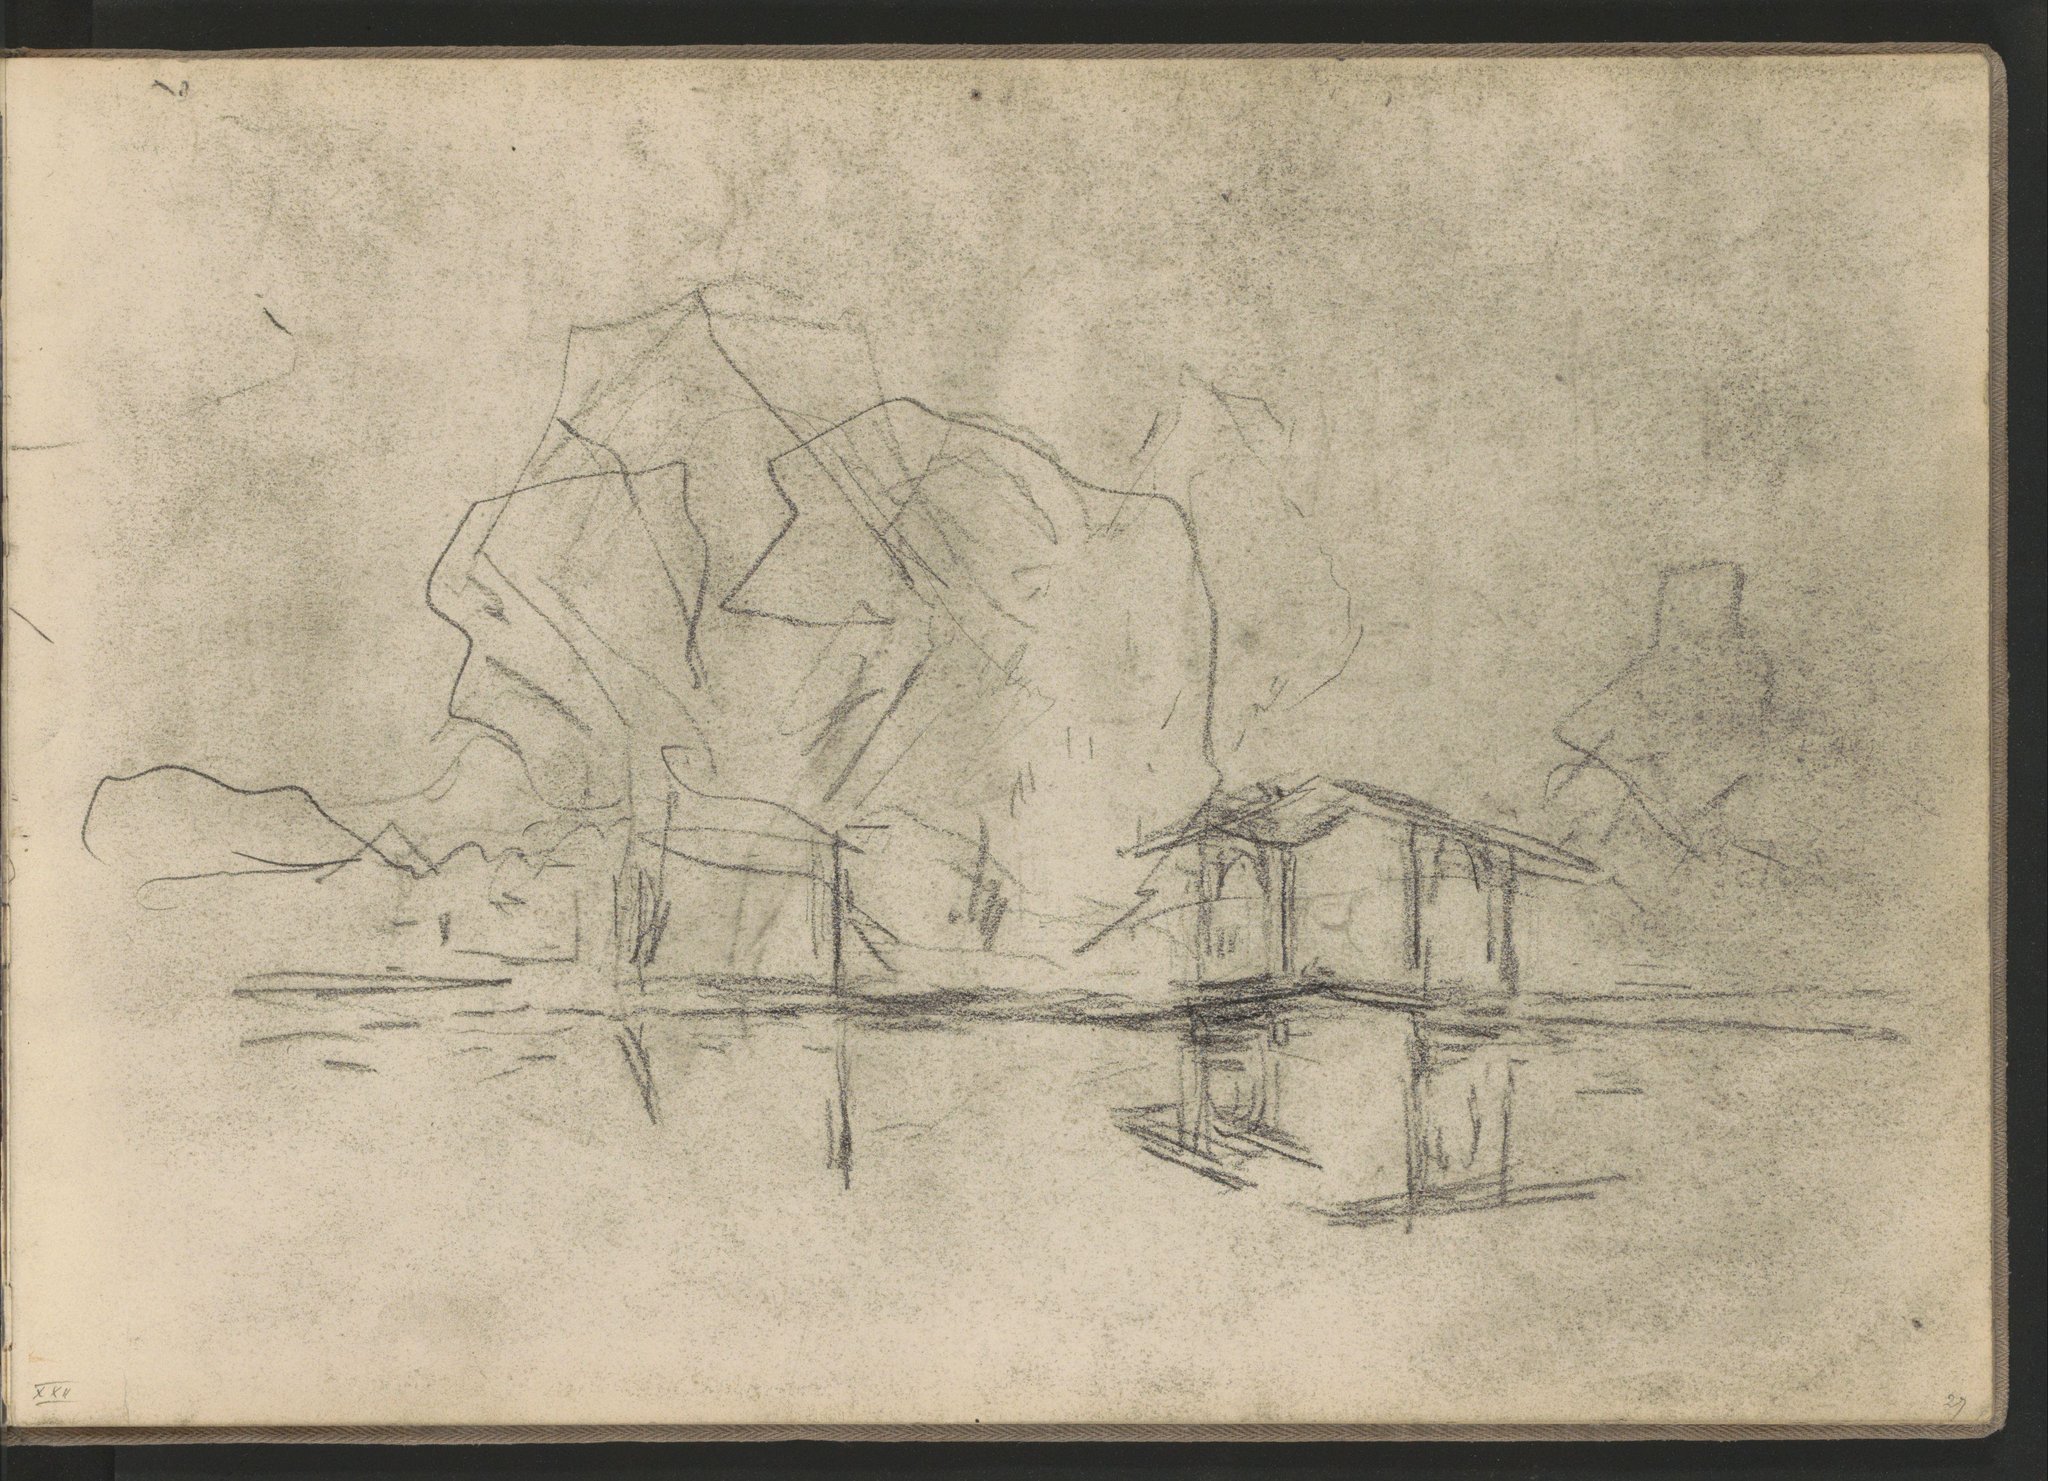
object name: sketchbook leaf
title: Huis en bomen aan een waterkant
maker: egbert rubertus derk schaap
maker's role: draughtsman, painter, print maker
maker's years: 1862-1939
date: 1891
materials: chalk, paper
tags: landscapes with waters, waterscapes, seascapes (in the temperate zone), civic architecture; edifices; dwellings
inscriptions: number: ‘XXII’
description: Pagina 27 uit een schetsboek met 64 pagina's.